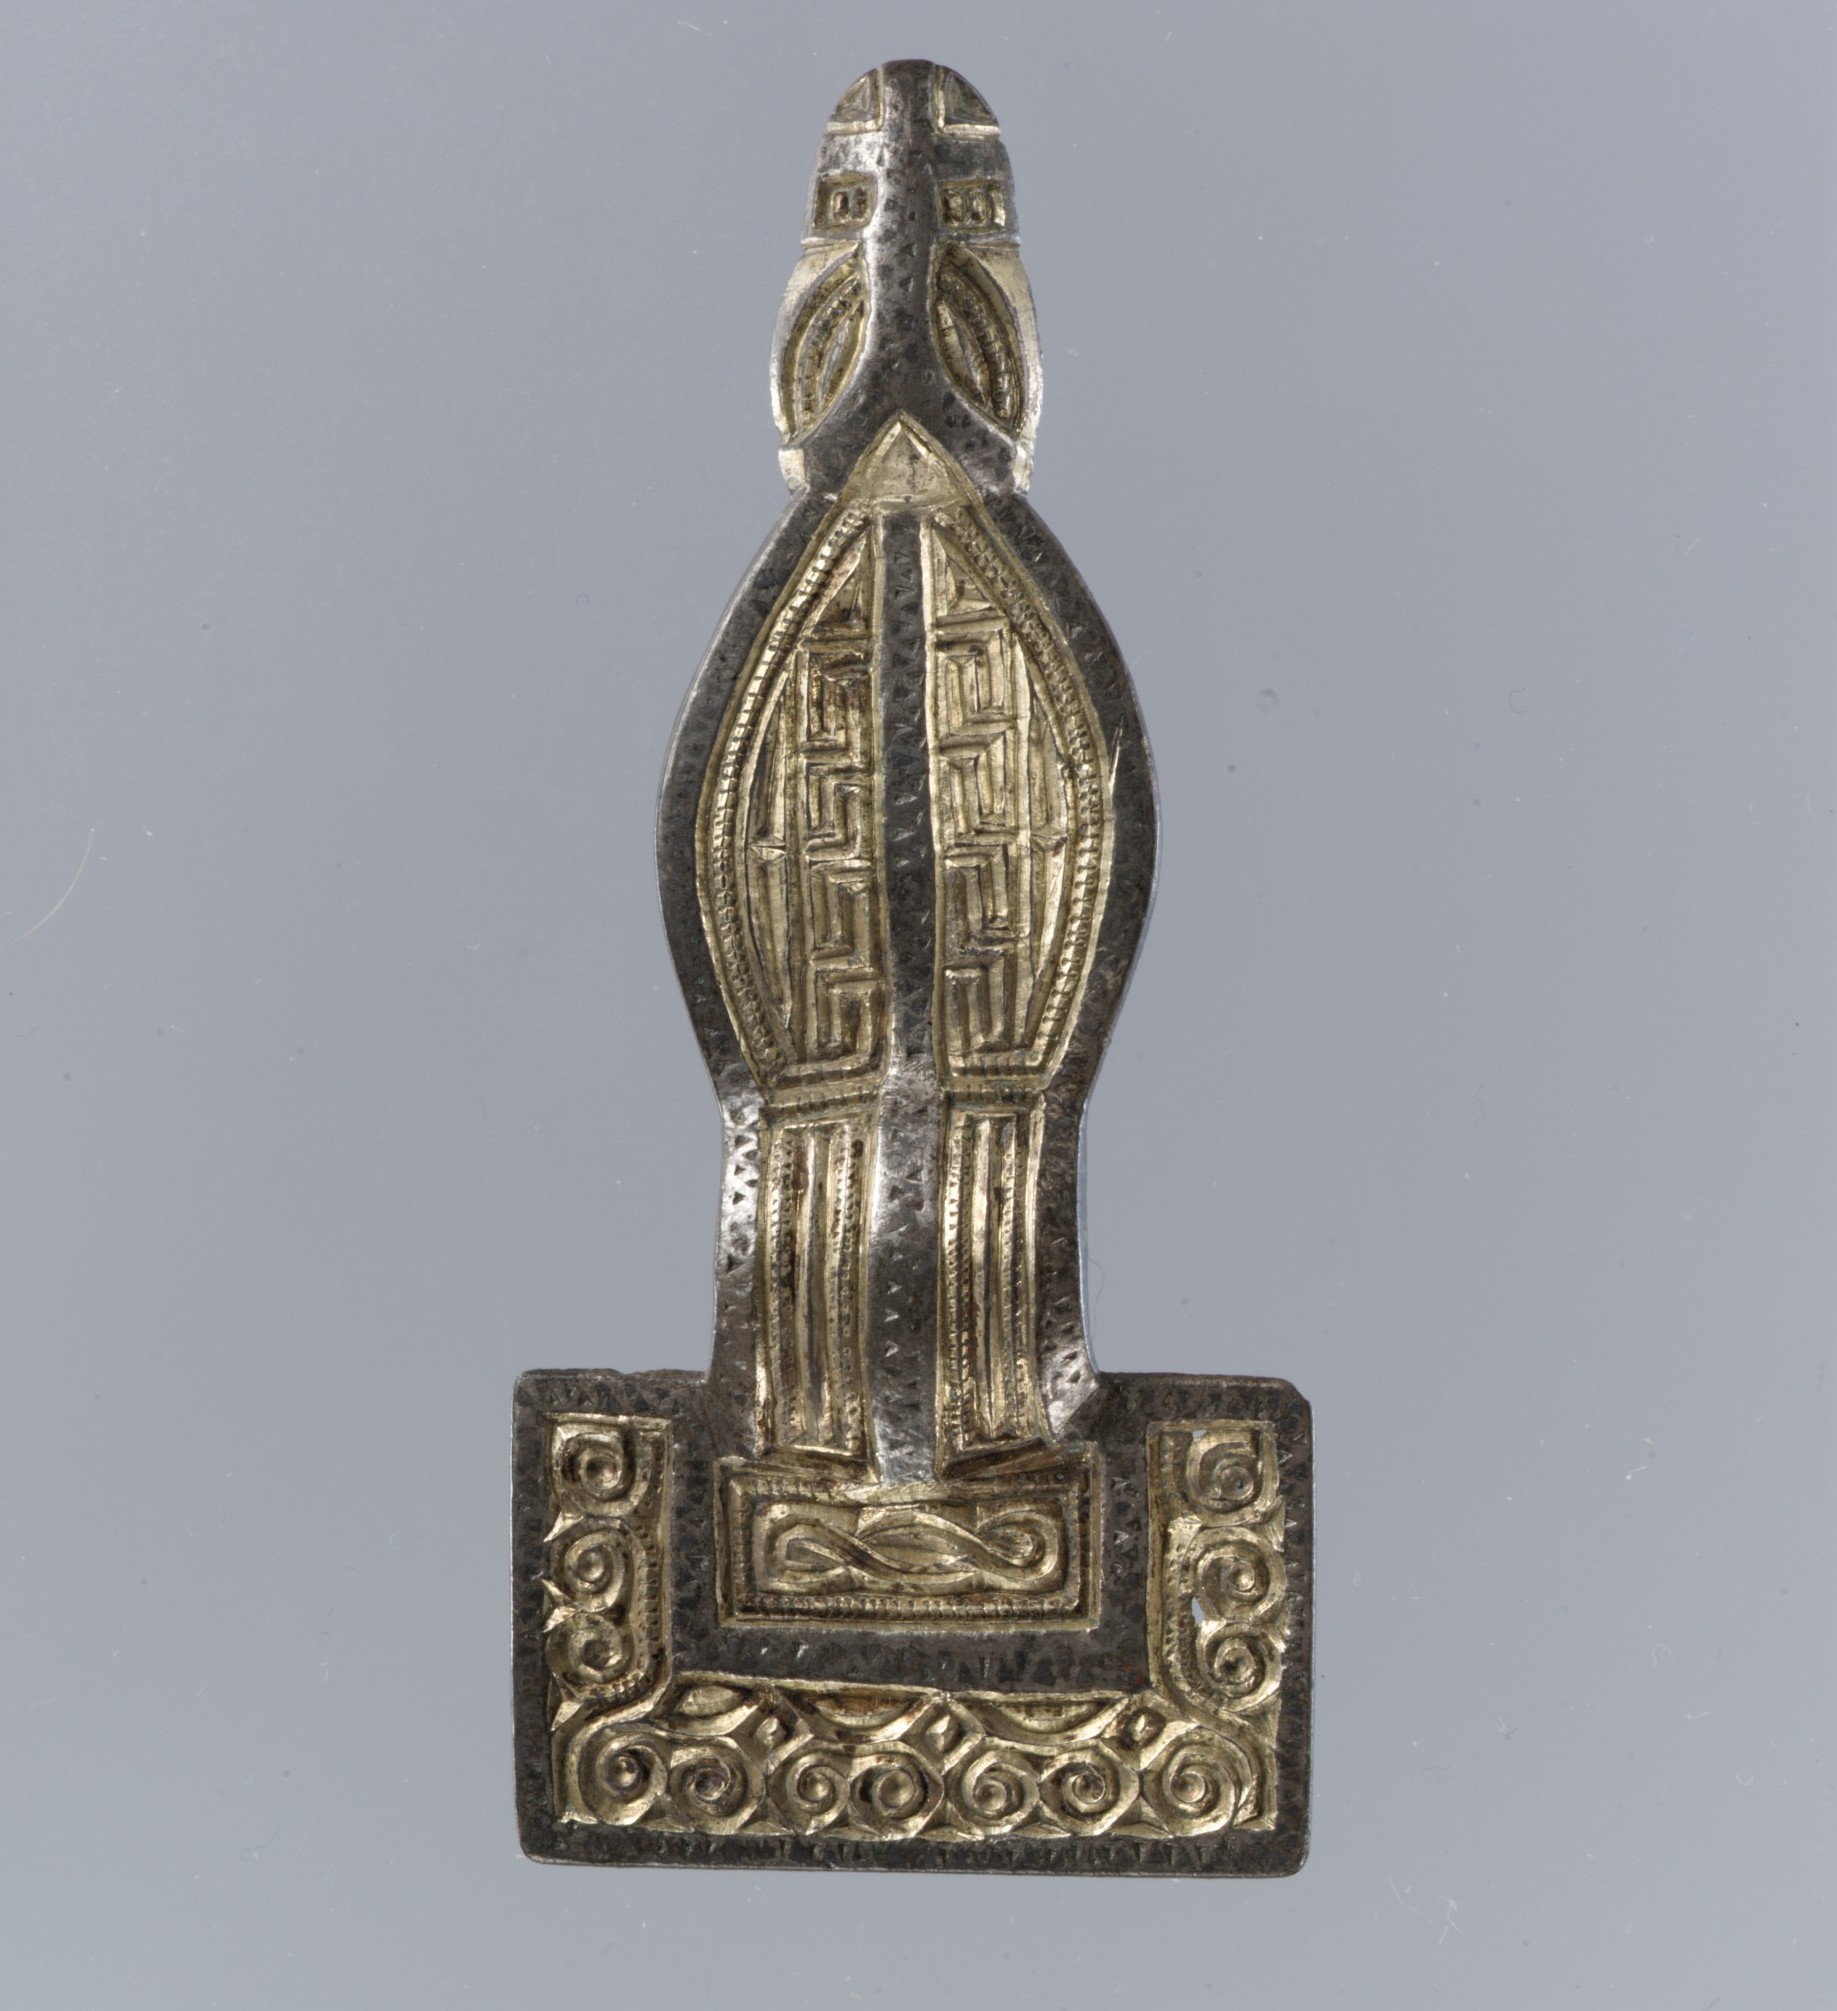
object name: brooch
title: Square-Headed Bow Brooch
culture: frankish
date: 551-600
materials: niello, silver gilt